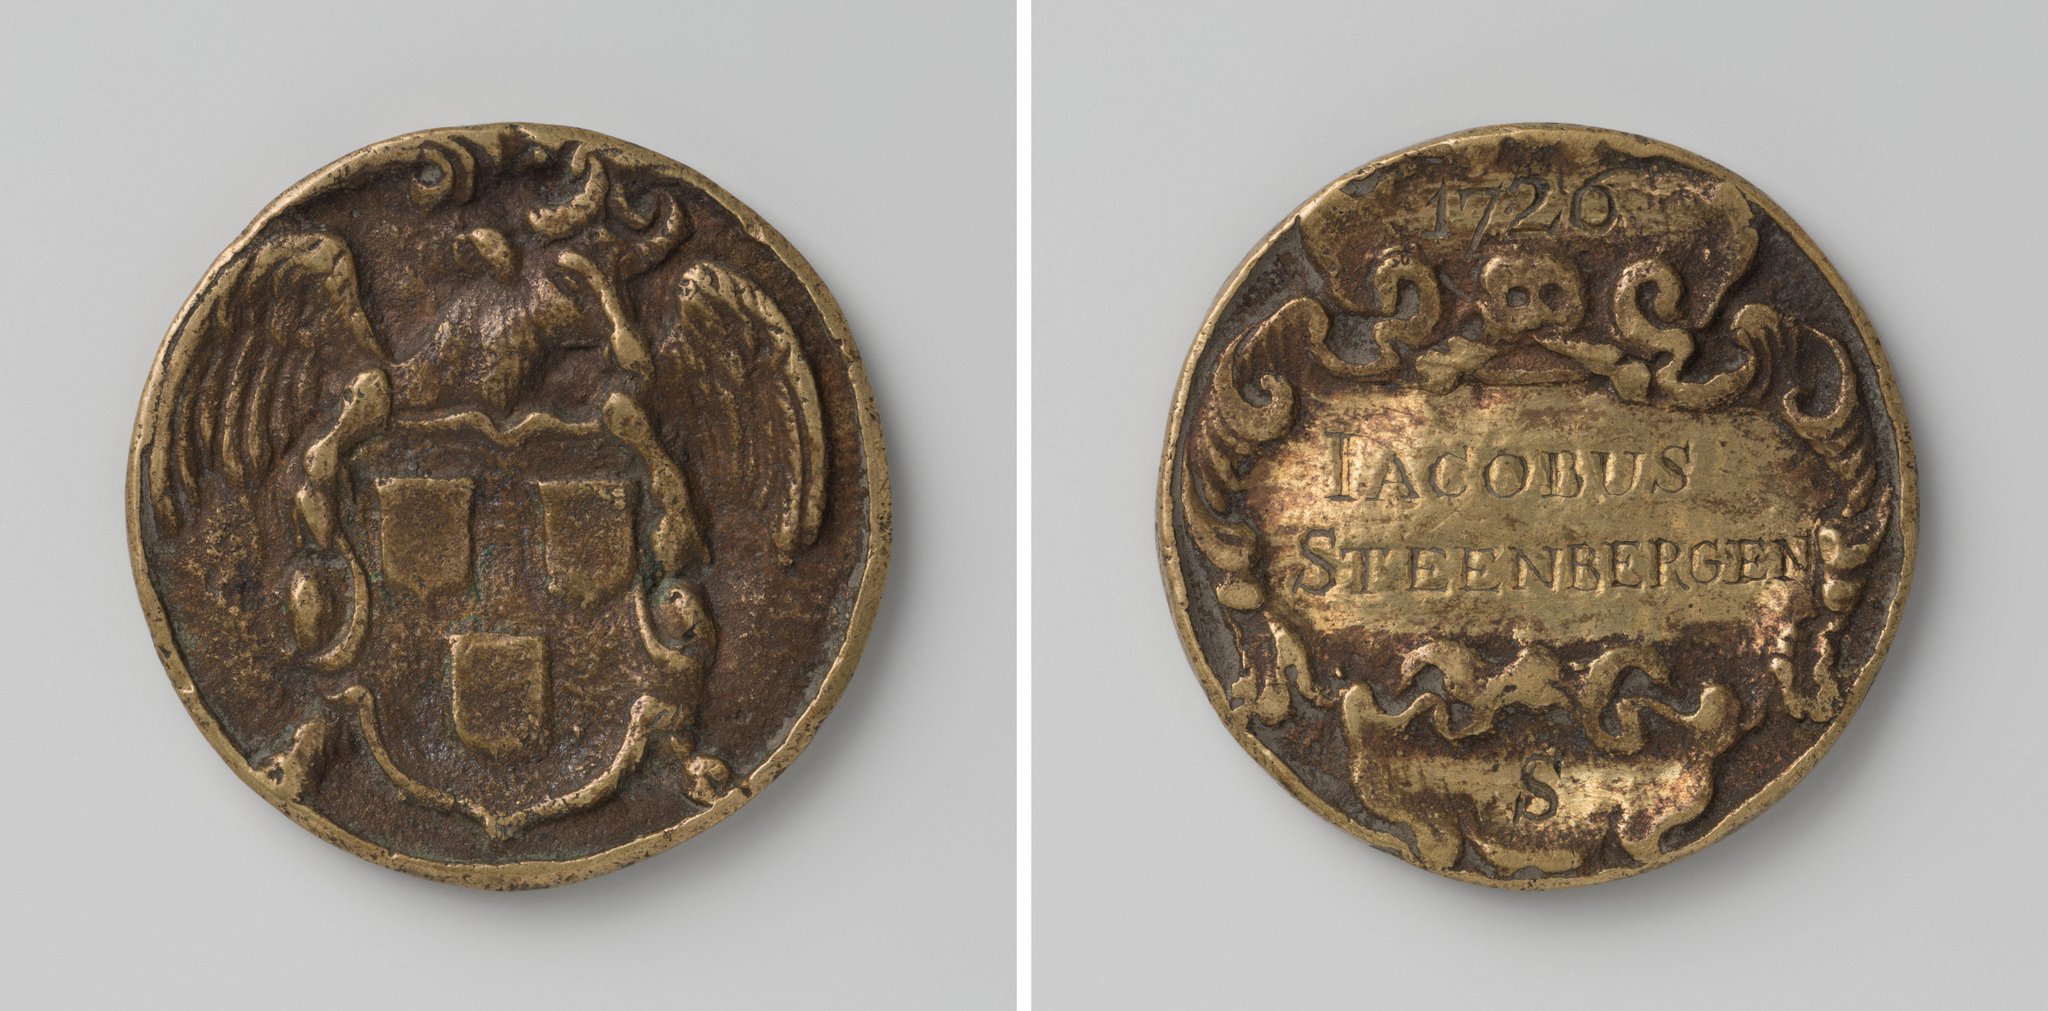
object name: medal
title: St. Lucasgilde van Amsterdam, gildepenning van Jacobus Steenbergen, schilder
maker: Anonymous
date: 1726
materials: brass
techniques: casting, engraving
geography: amsterdam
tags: amsterdam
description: Messing penning. Voorzijde: gevleugelde os houdt Lucasschild in zijn poten. Keerzijde: cartouche met opschrift onder doodshoofd en beenderen, en cartouche met jaartal, boven cartouche met letter S